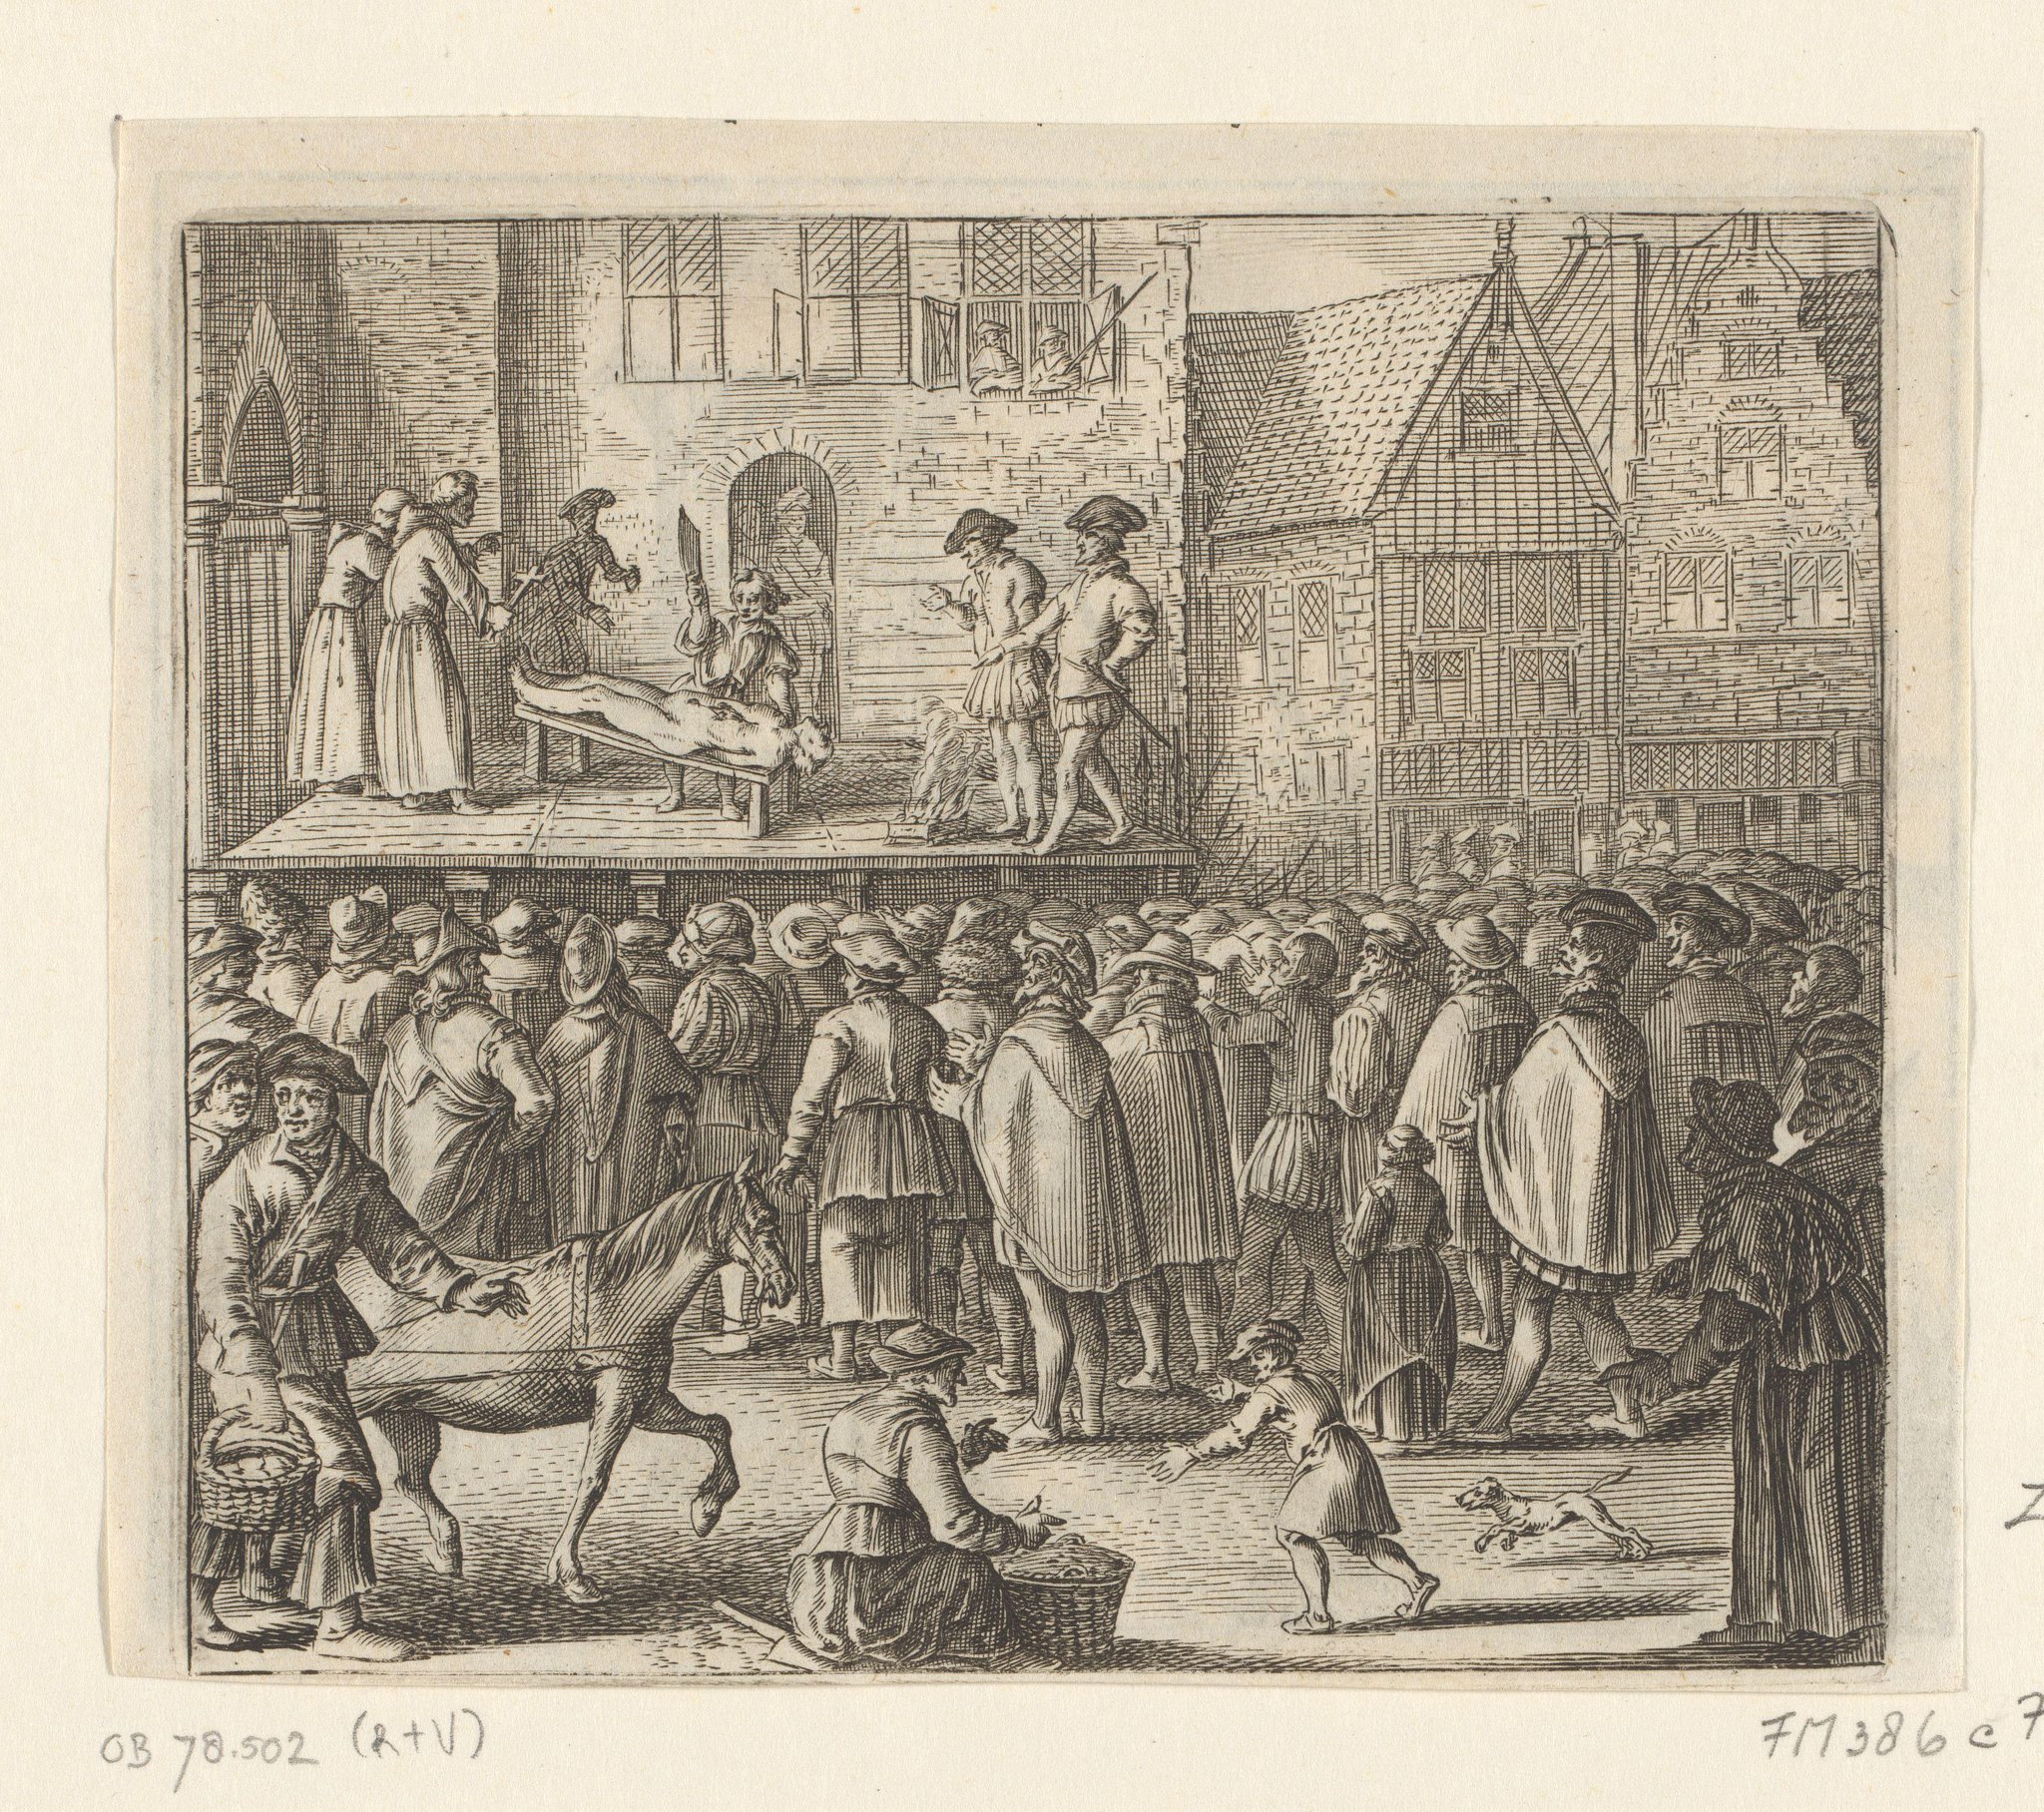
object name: history print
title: Terechtstelling van de wederdopers op het schavot op de Dam, 1535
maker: Anonymous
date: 1650-1699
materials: paper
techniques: engraving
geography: northern netherlands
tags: on the scaffold or place of execution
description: Illustratie voor een onbekend werk. Deze prenten zijn gebaseerd op de anonieme gravures in de eerste uitgave Hortensius' Van den oproer der weder-dooperen uit 1614. Kopieën naar FMH 386, Niet in Frederik Muller; door het RPK toegevoegd nummer. Naar het verloren gegane schilderij van Barend Dircksz. in het oude stadhuis te Amsterdam.